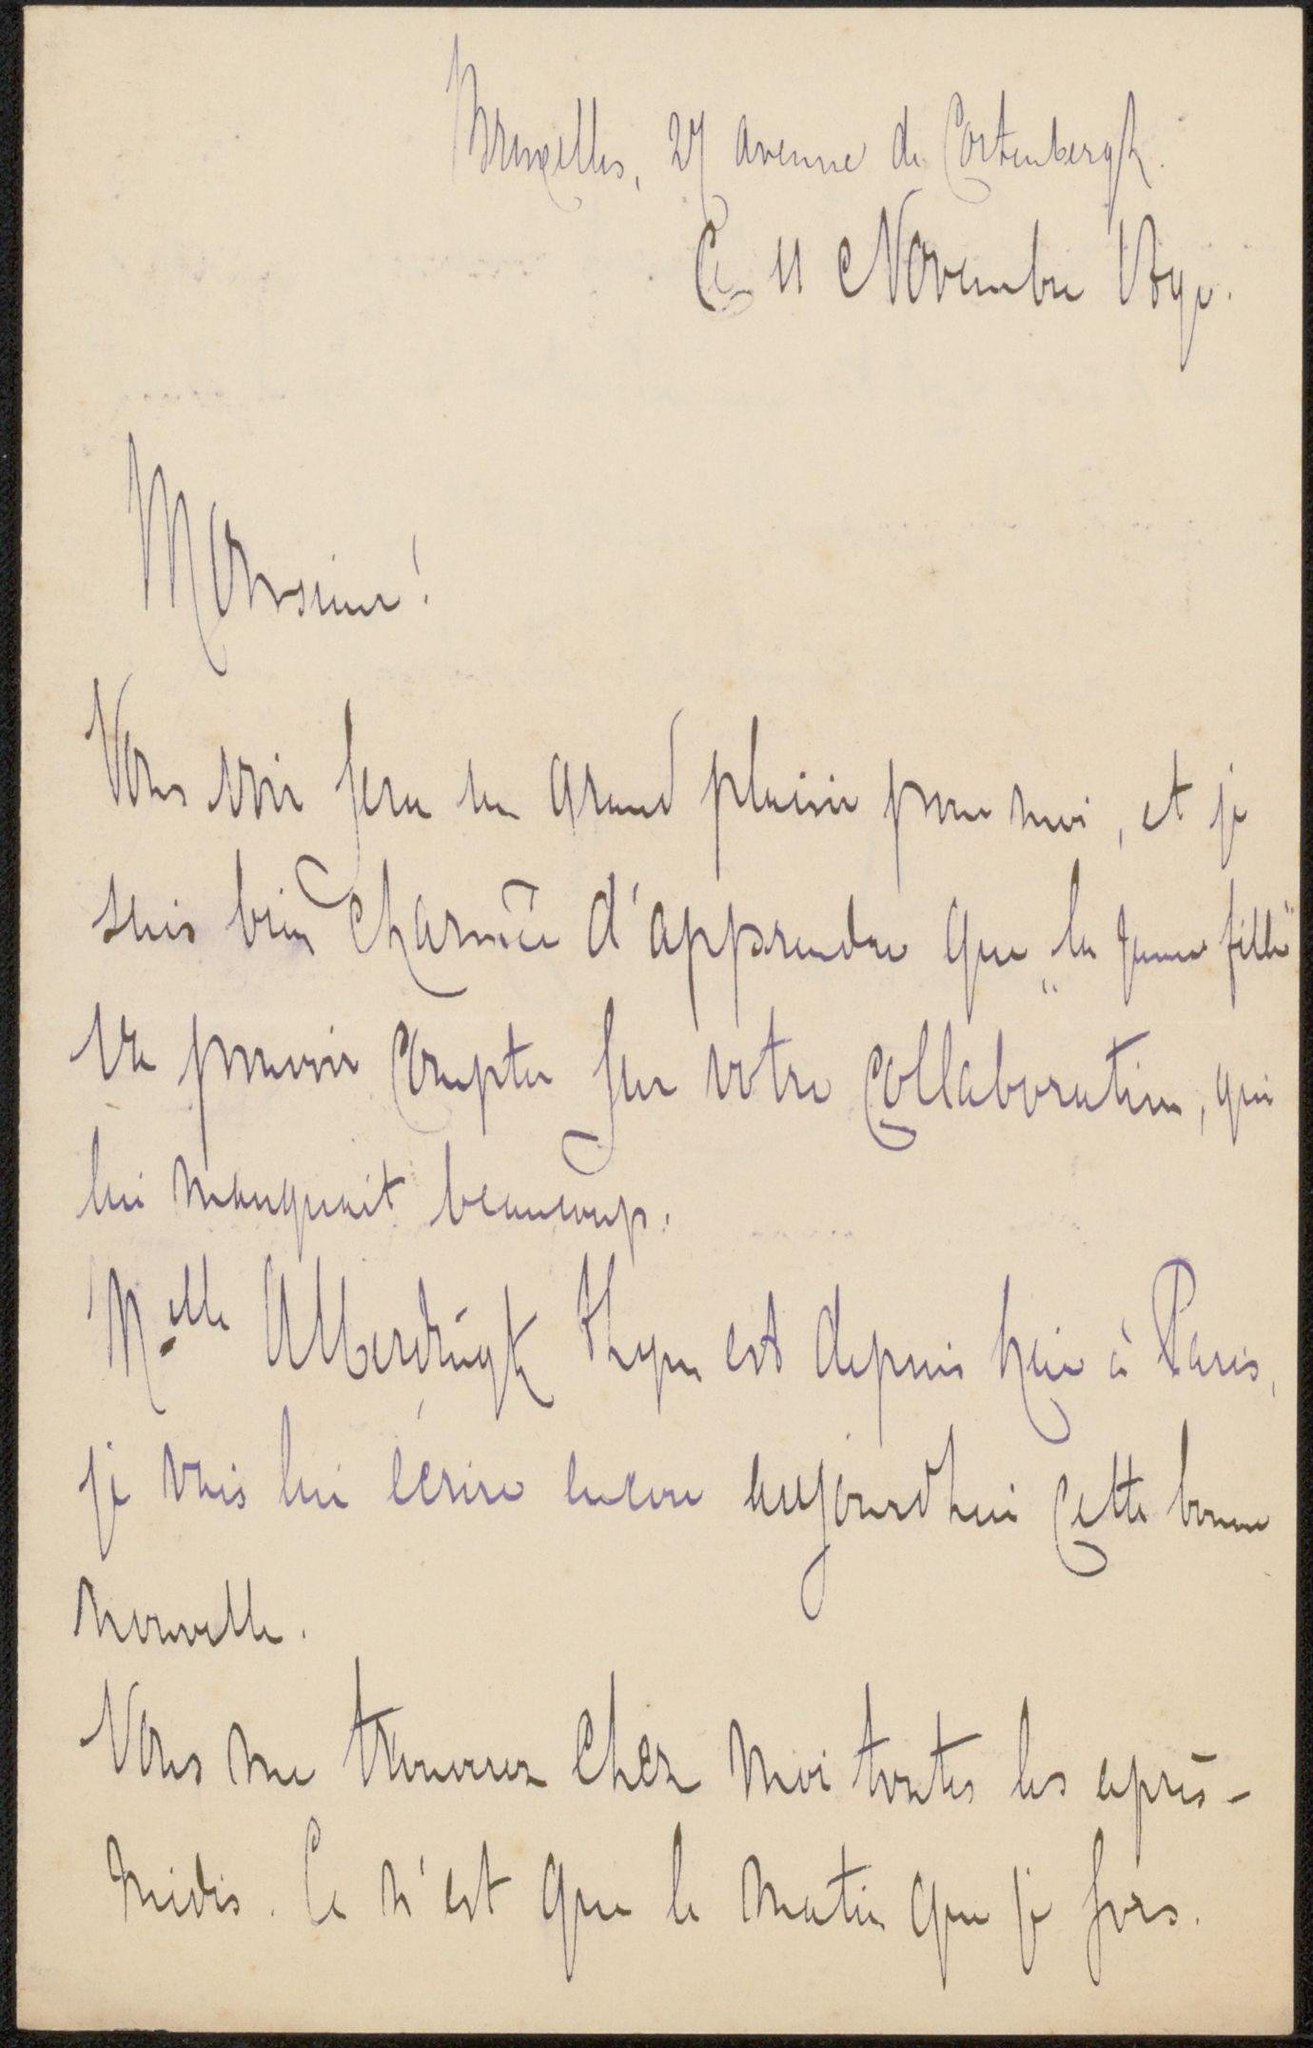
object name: letter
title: Brief aan Philip Zilcken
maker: louise stratenus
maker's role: schrijver, vertaler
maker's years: 1852-1908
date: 1890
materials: ink, paper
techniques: pen, writing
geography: brussels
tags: amsterdam, catharina alberdingk thijm, the hague, draughtsman, philip zilcken, paris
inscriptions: collector's mark: ‘RPK’, watermark